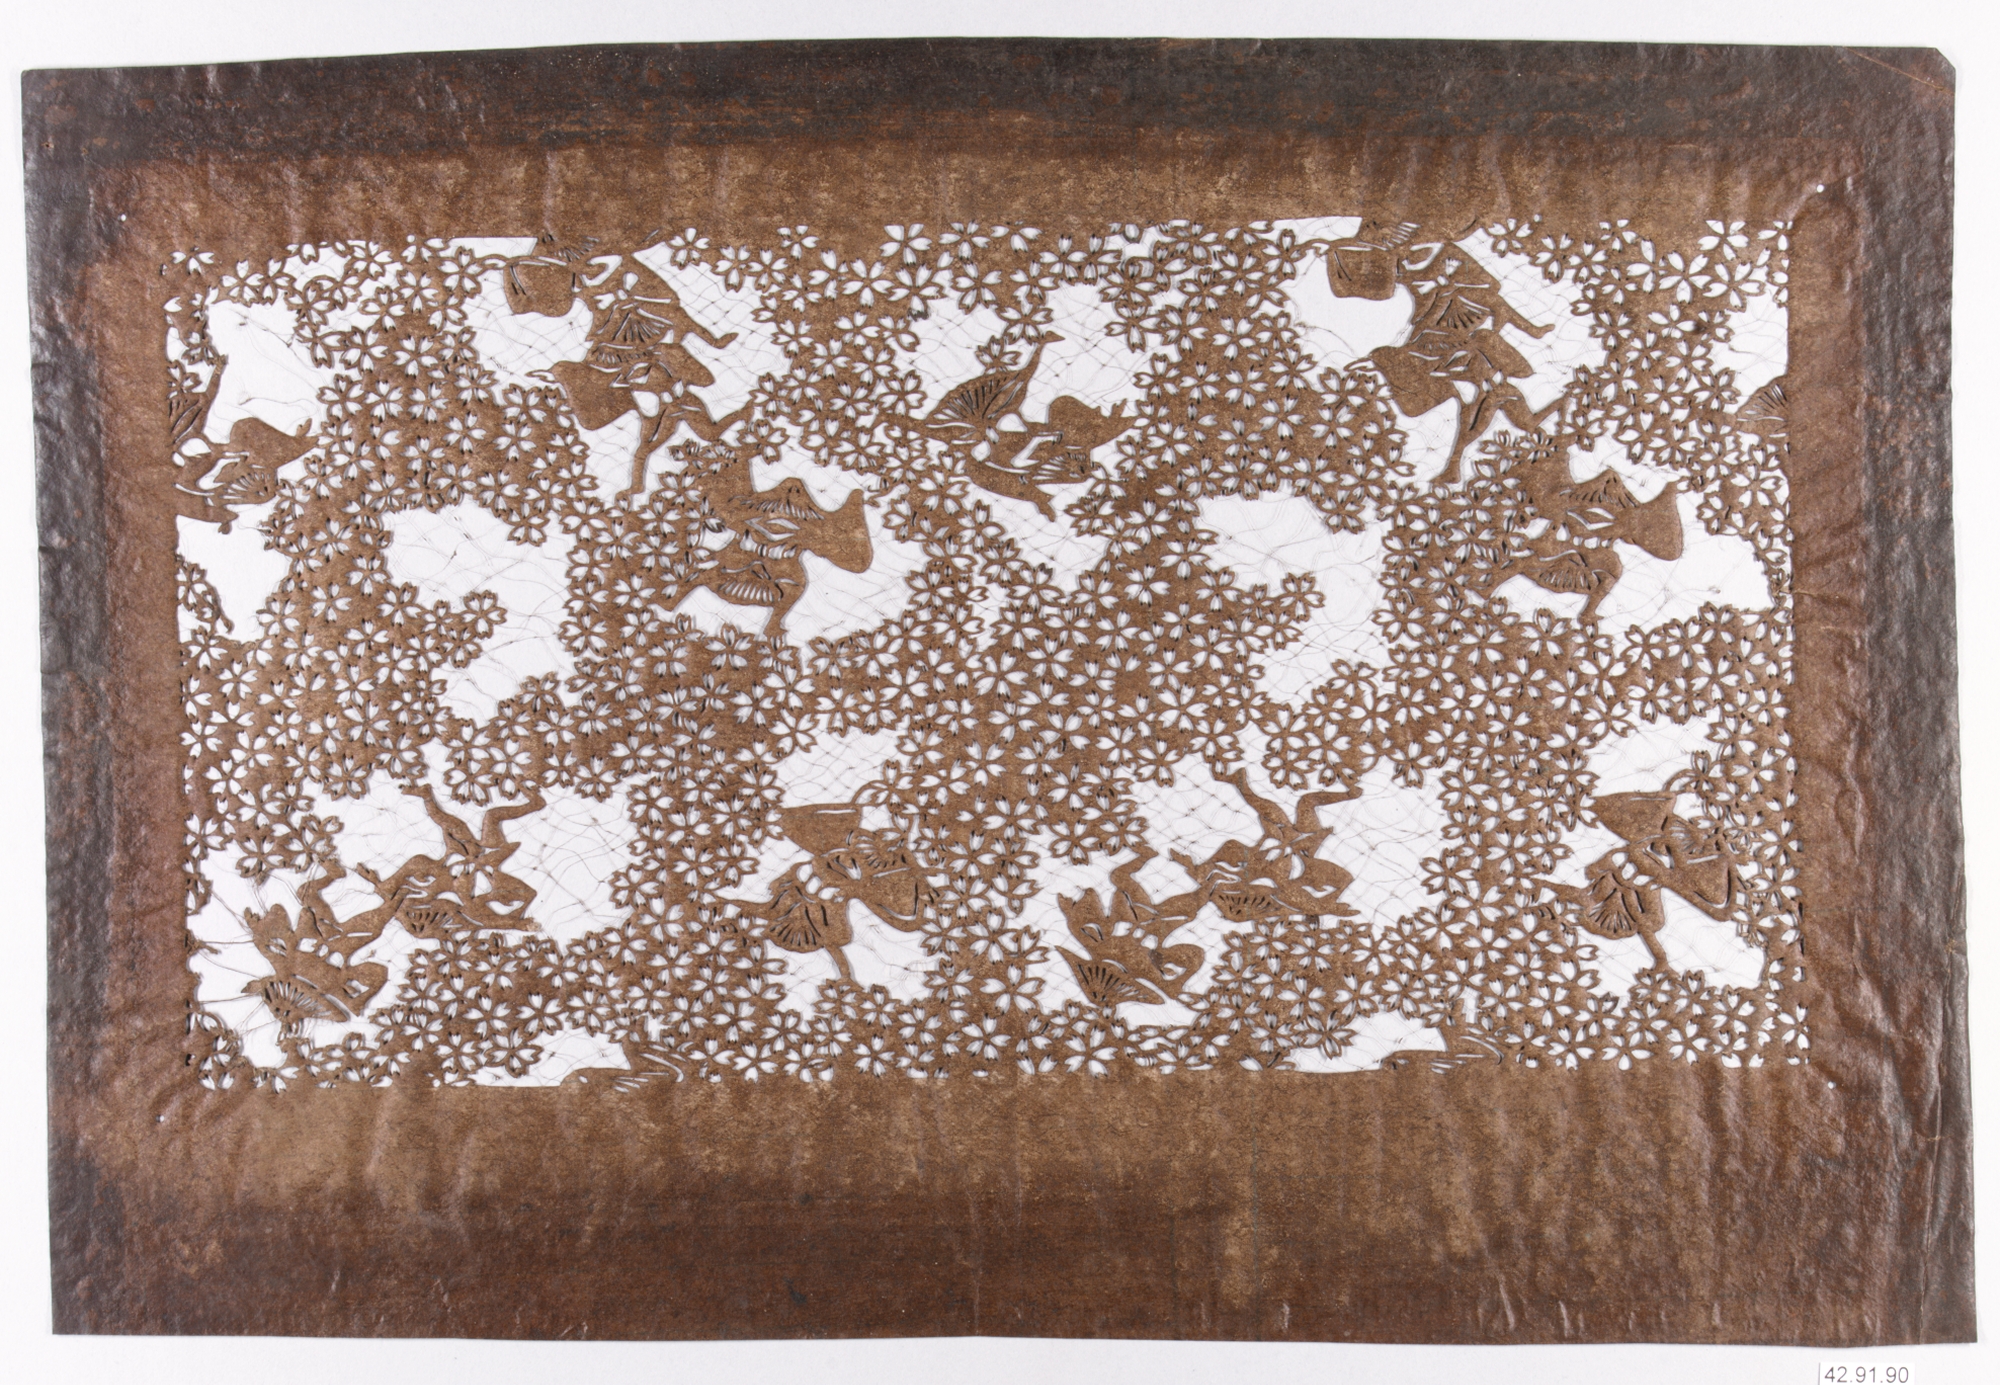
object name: stencil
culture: japanese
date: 1801-1900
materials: paper, silk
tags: human figures,flowers